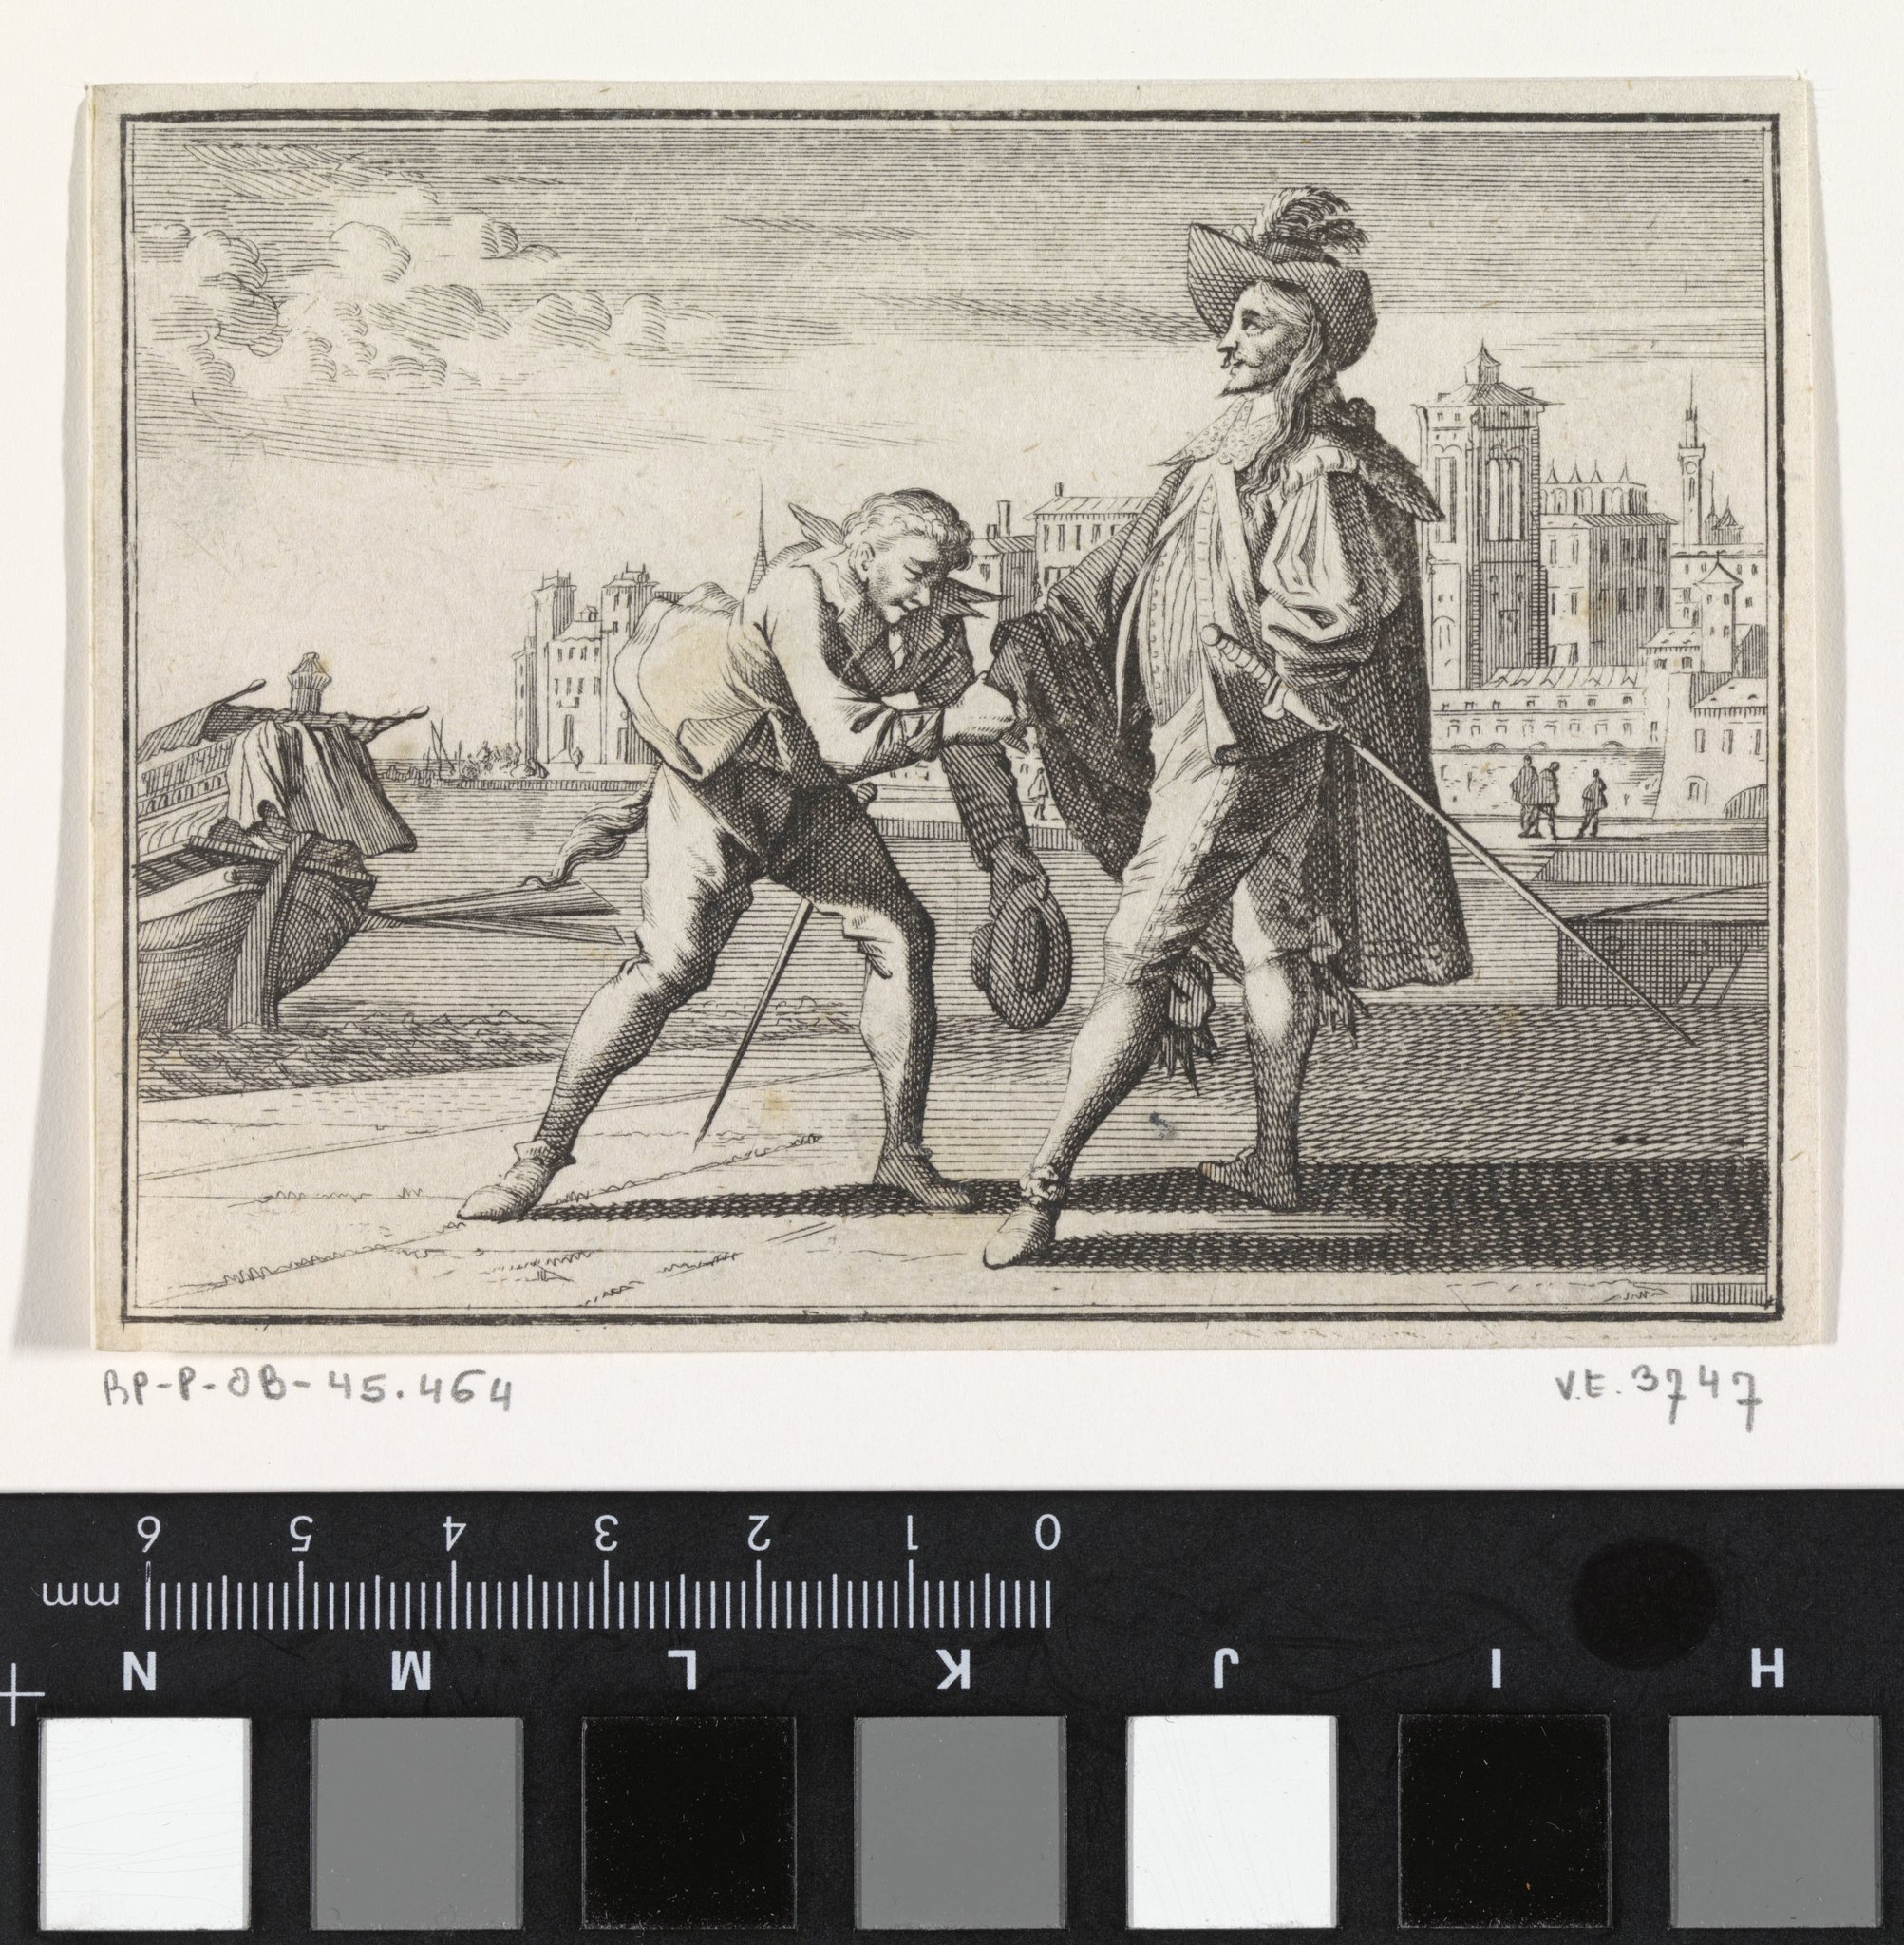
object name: book illustration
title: Die Stimm im Wald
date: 1710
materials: paper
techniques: etching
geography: nuremberg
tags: pier, quay, wharf, kissing the hand (lovers)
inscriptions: collector's mark: Lugt 240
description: Illustratie uit: Abraham a Sancta Clara. Heilsames Gemisch Gemasch, das ist: Allerley seltsame und verwunderliche Geschichten (...). Neurenberg: Christoph Weigel, 1710, p. 20.